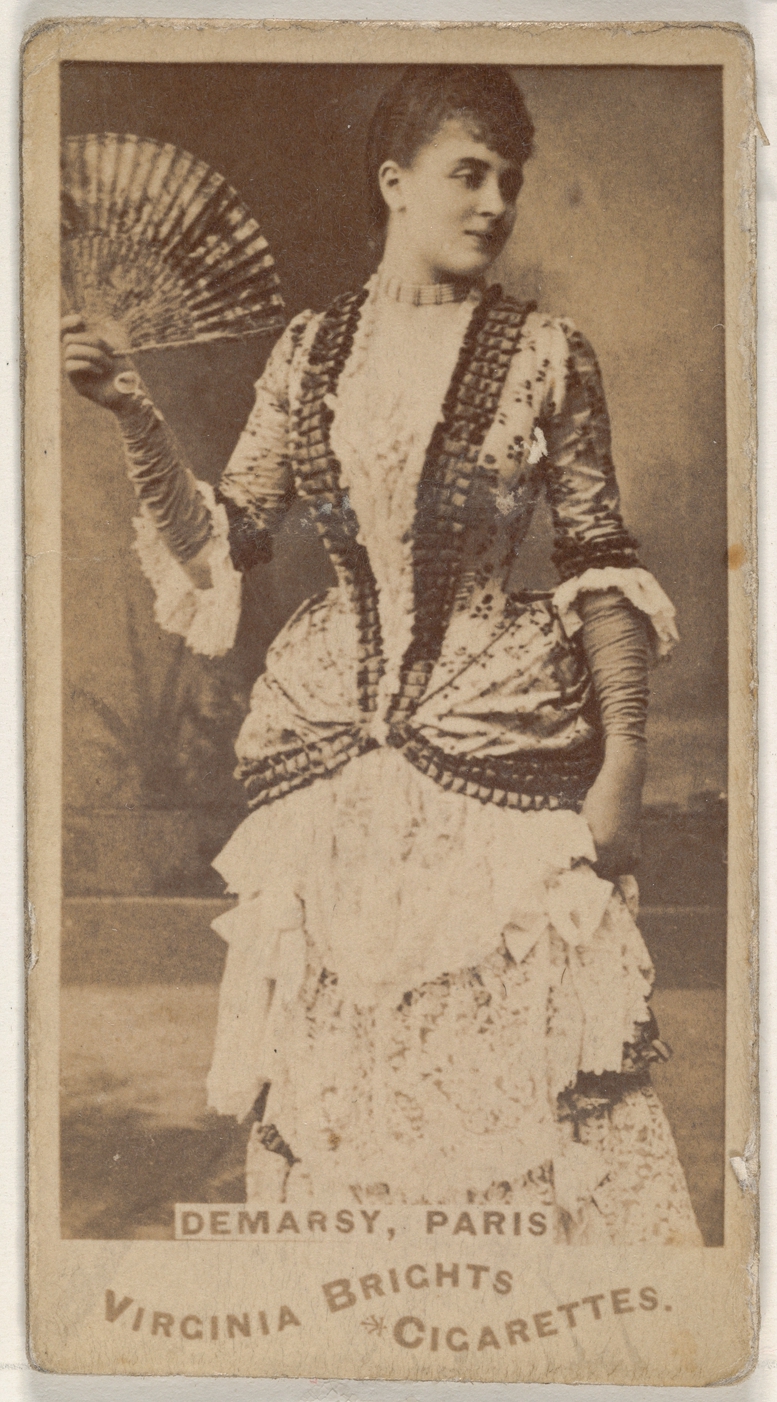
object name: photograph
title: Demarsy, Paris, from the Actors and Actresses series (N45, Type 1) for Virginia Brights Cigarettes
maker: allen & ginter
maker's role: publisher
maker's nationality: american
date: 1888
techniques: albumen silver print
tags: fans,portraits,women,actresses